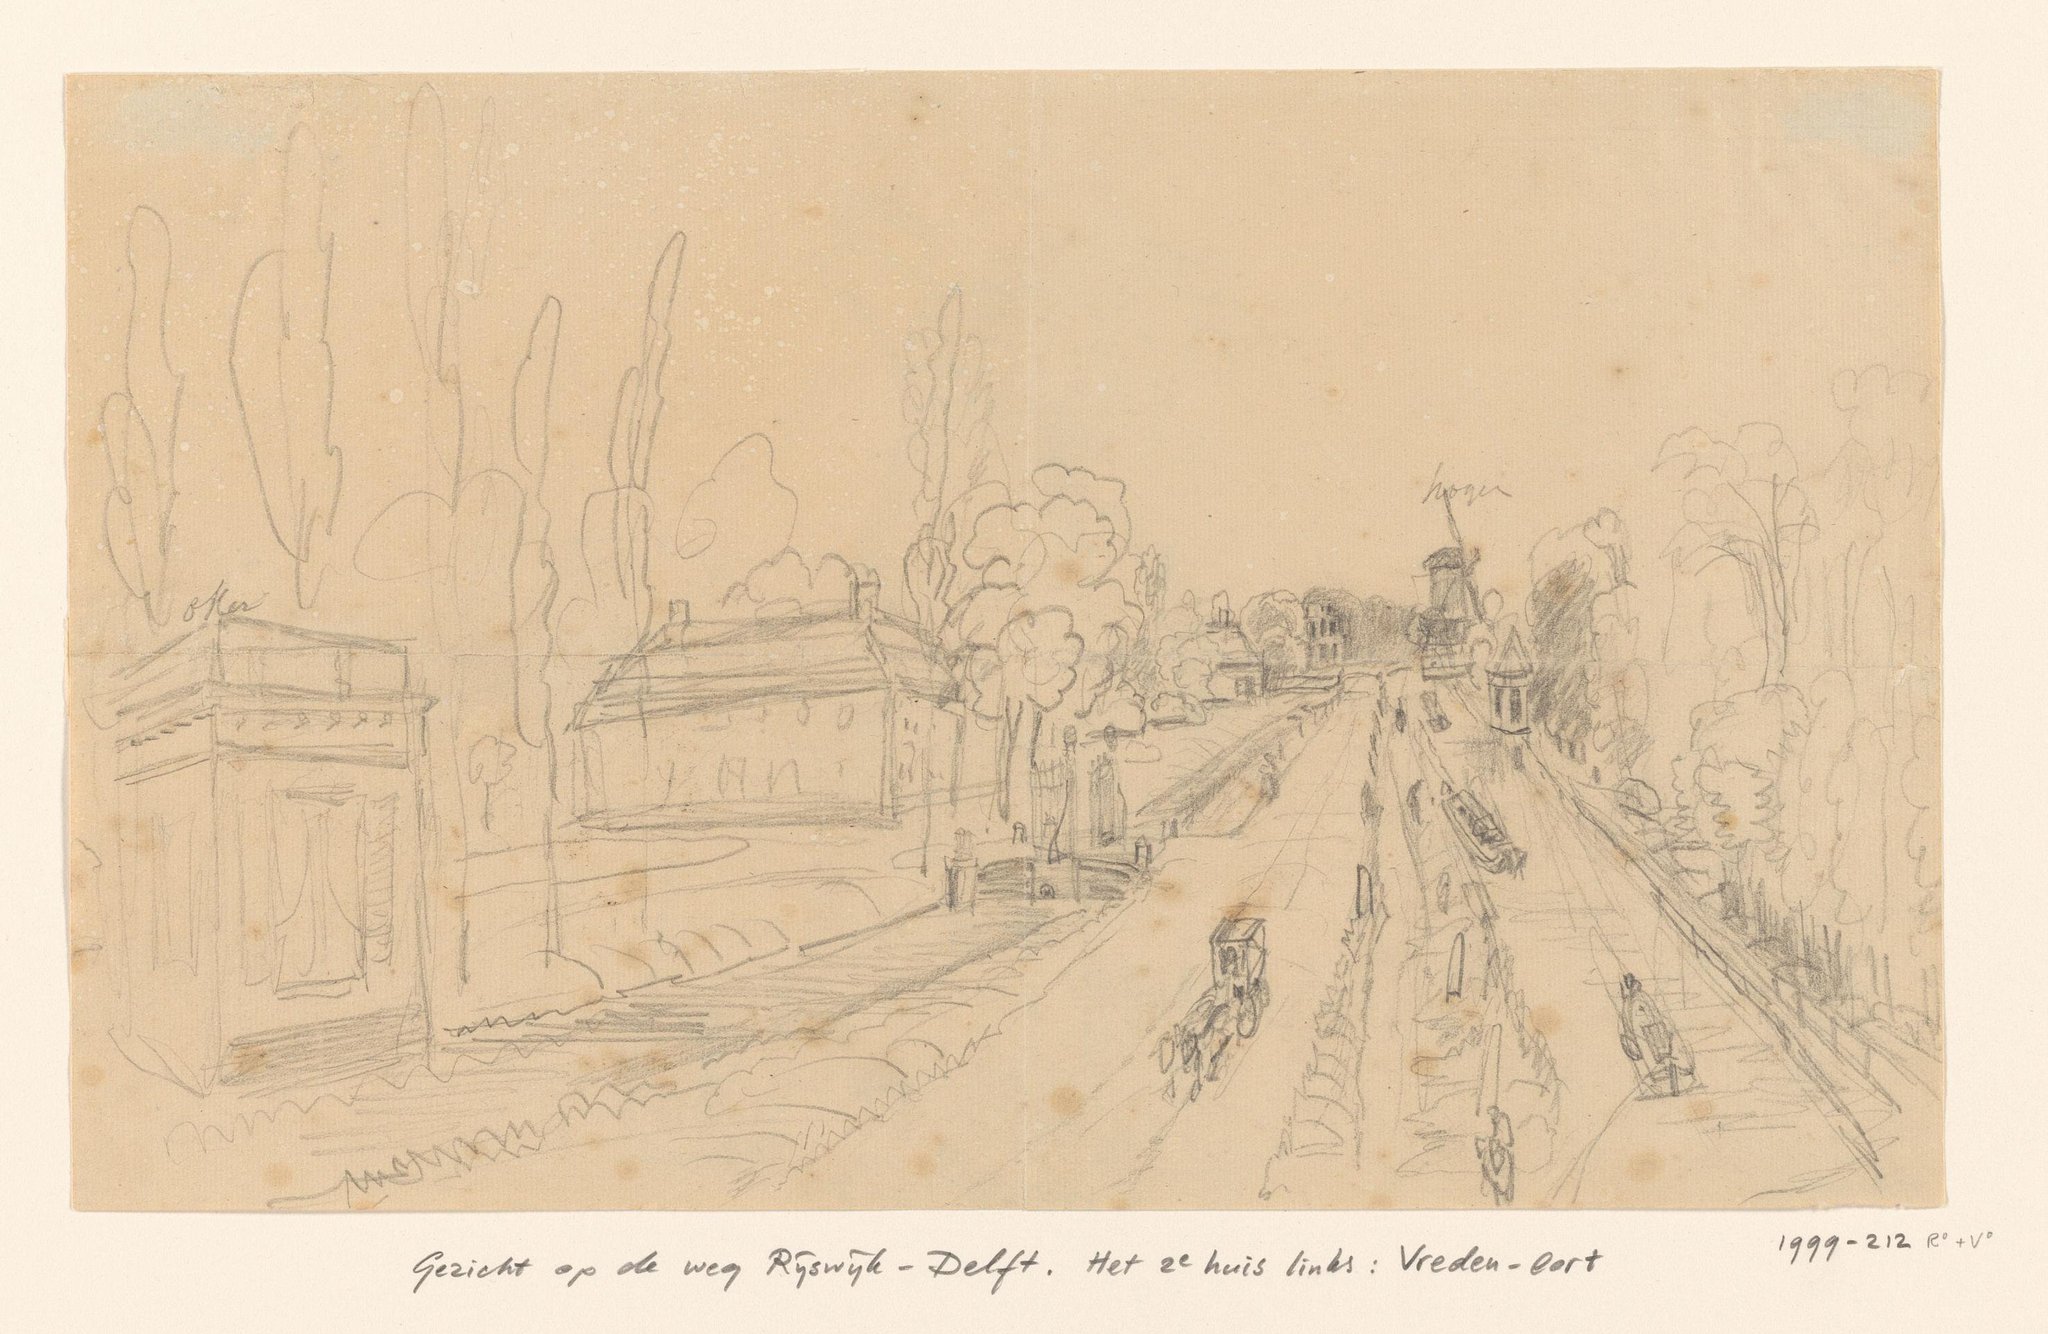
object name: drawing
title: Gezicht op de weg Rijswijk-Delft, Zuid-Holland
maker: adrianus johannes bik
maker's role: draughtsman, print maker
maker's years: 1790-1872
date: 1860-1870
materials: paper, pencil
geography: rijswijk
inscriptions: annotation: ‘2e huis links Vreedeoort (naar de broer van overgroot pa n.l. Vreede Bik) gelegen aan de weg Rijswijk-Delft’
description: Gezicht op de weg Rijswijk-Delft, Zuid-Holland; het 2e huis links is Vreedeoort, het huis van Pieter Vreede Bik (1806-1883), jongere broer van Jan en Theodoor.